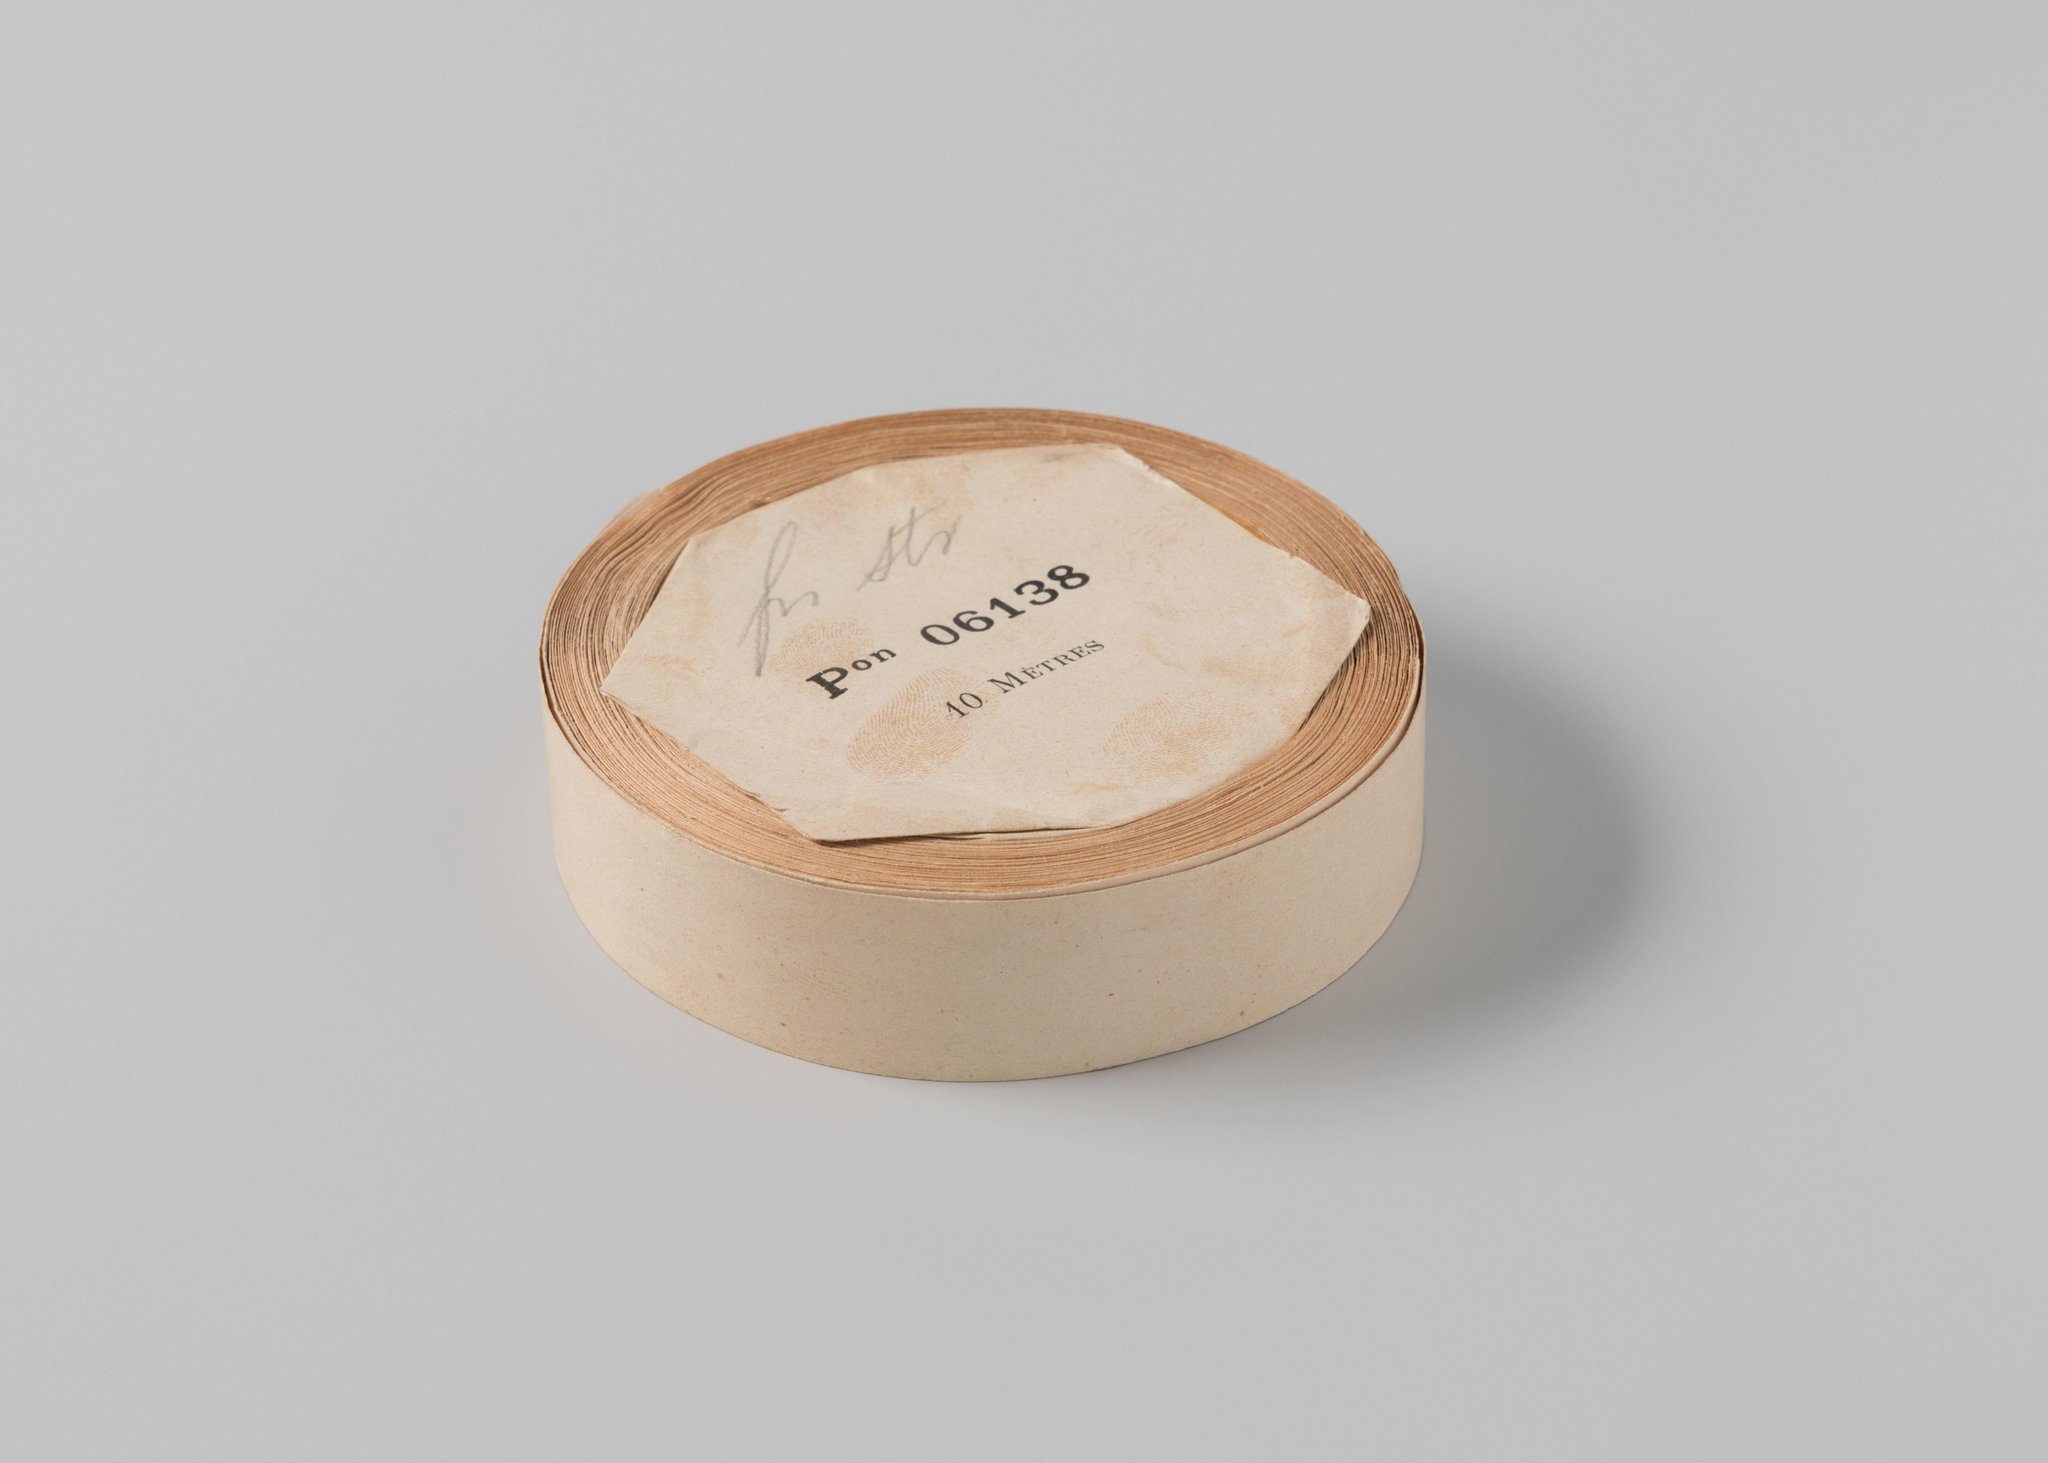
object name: ribbon material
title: Rol met paars lint met één gerafelde zijde en drie witte horizontale strepen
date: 1935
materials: cardboard, paper, textile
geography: nijmegen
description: Rol met paars lint met één gerafelde zijde en drie witte horizontale strepen.